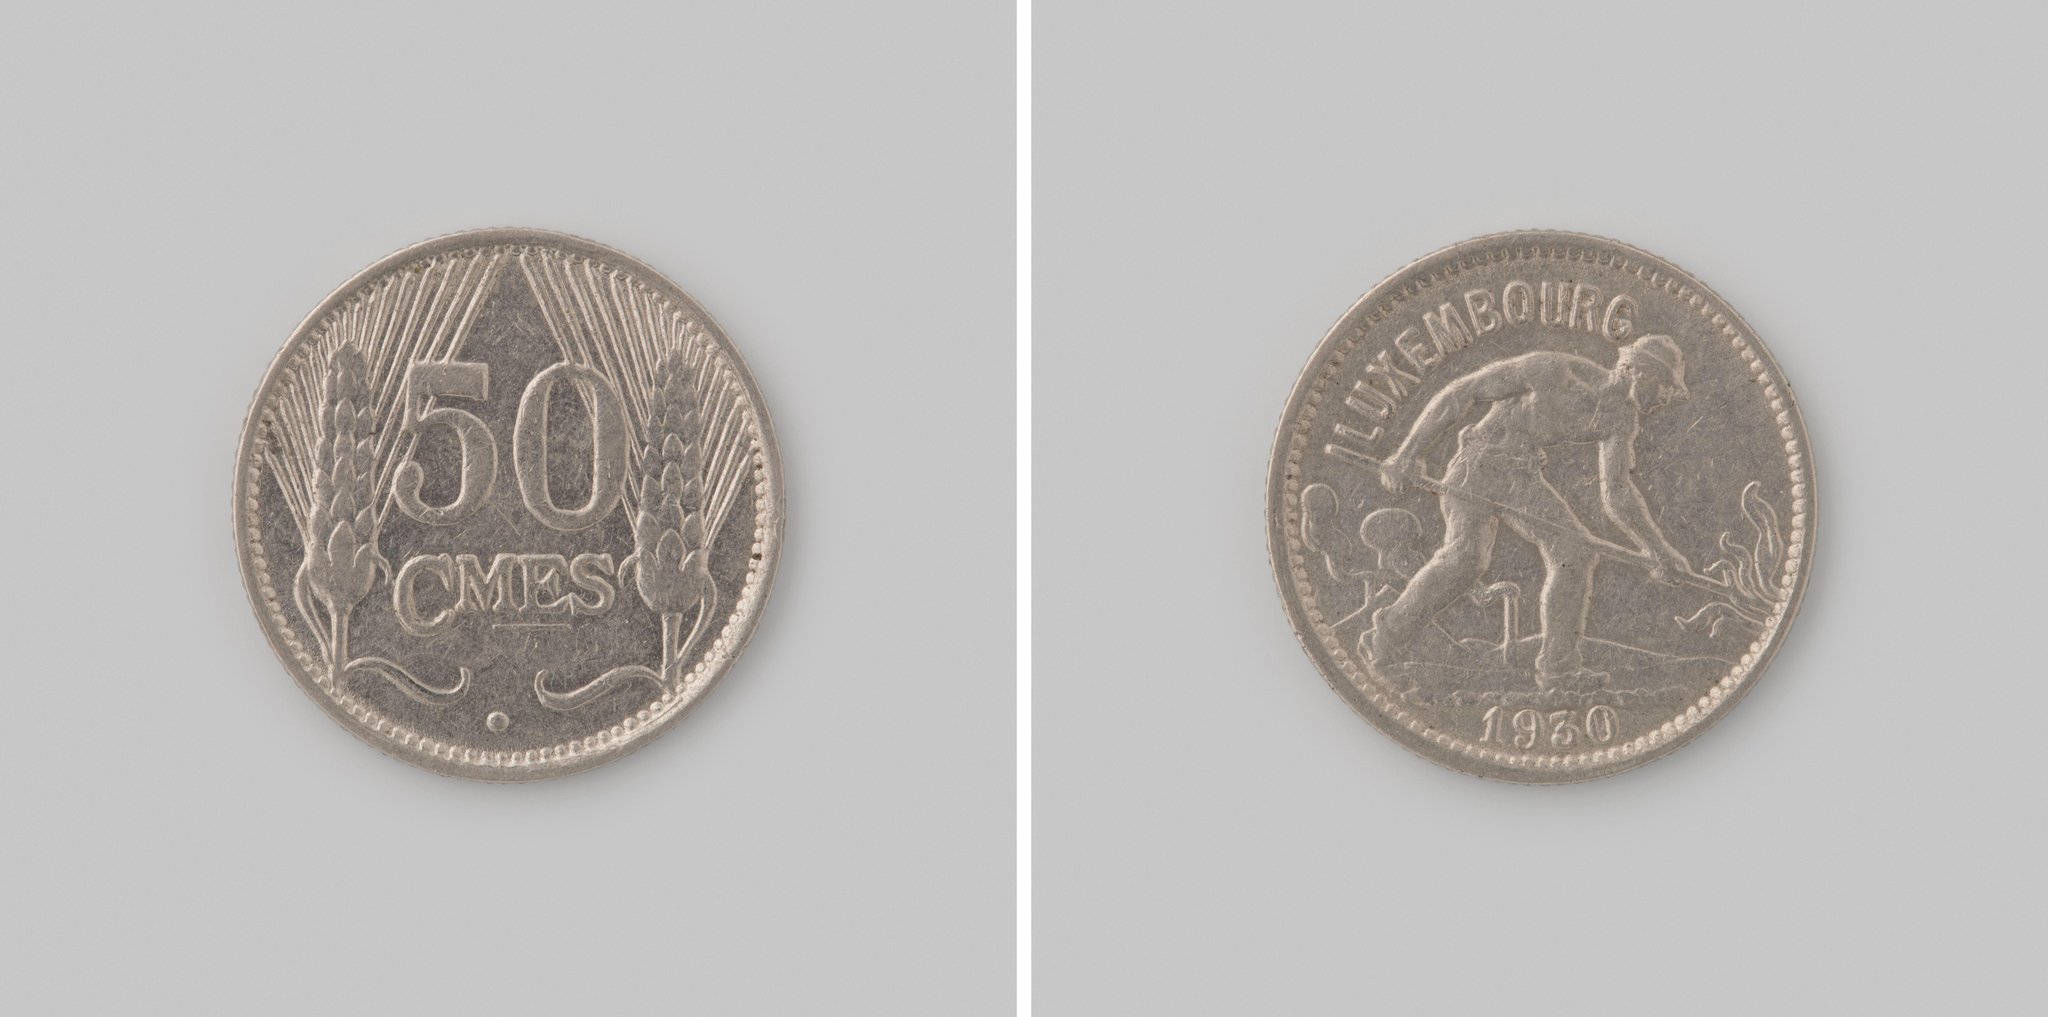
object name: vijftig centime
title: 50 centimes uit Luxemburg van Charlotte, 1930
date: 1930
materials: nickel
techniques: striking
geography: brussels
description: Nikkelen munt. Voorzijde: tussen twee korenaren waarde-aanduiding. Keerzijde: tegen achtergrond van industriële activiteiten stoker met schep naar rechts. Jaartal in afsnede. Kartelrand.